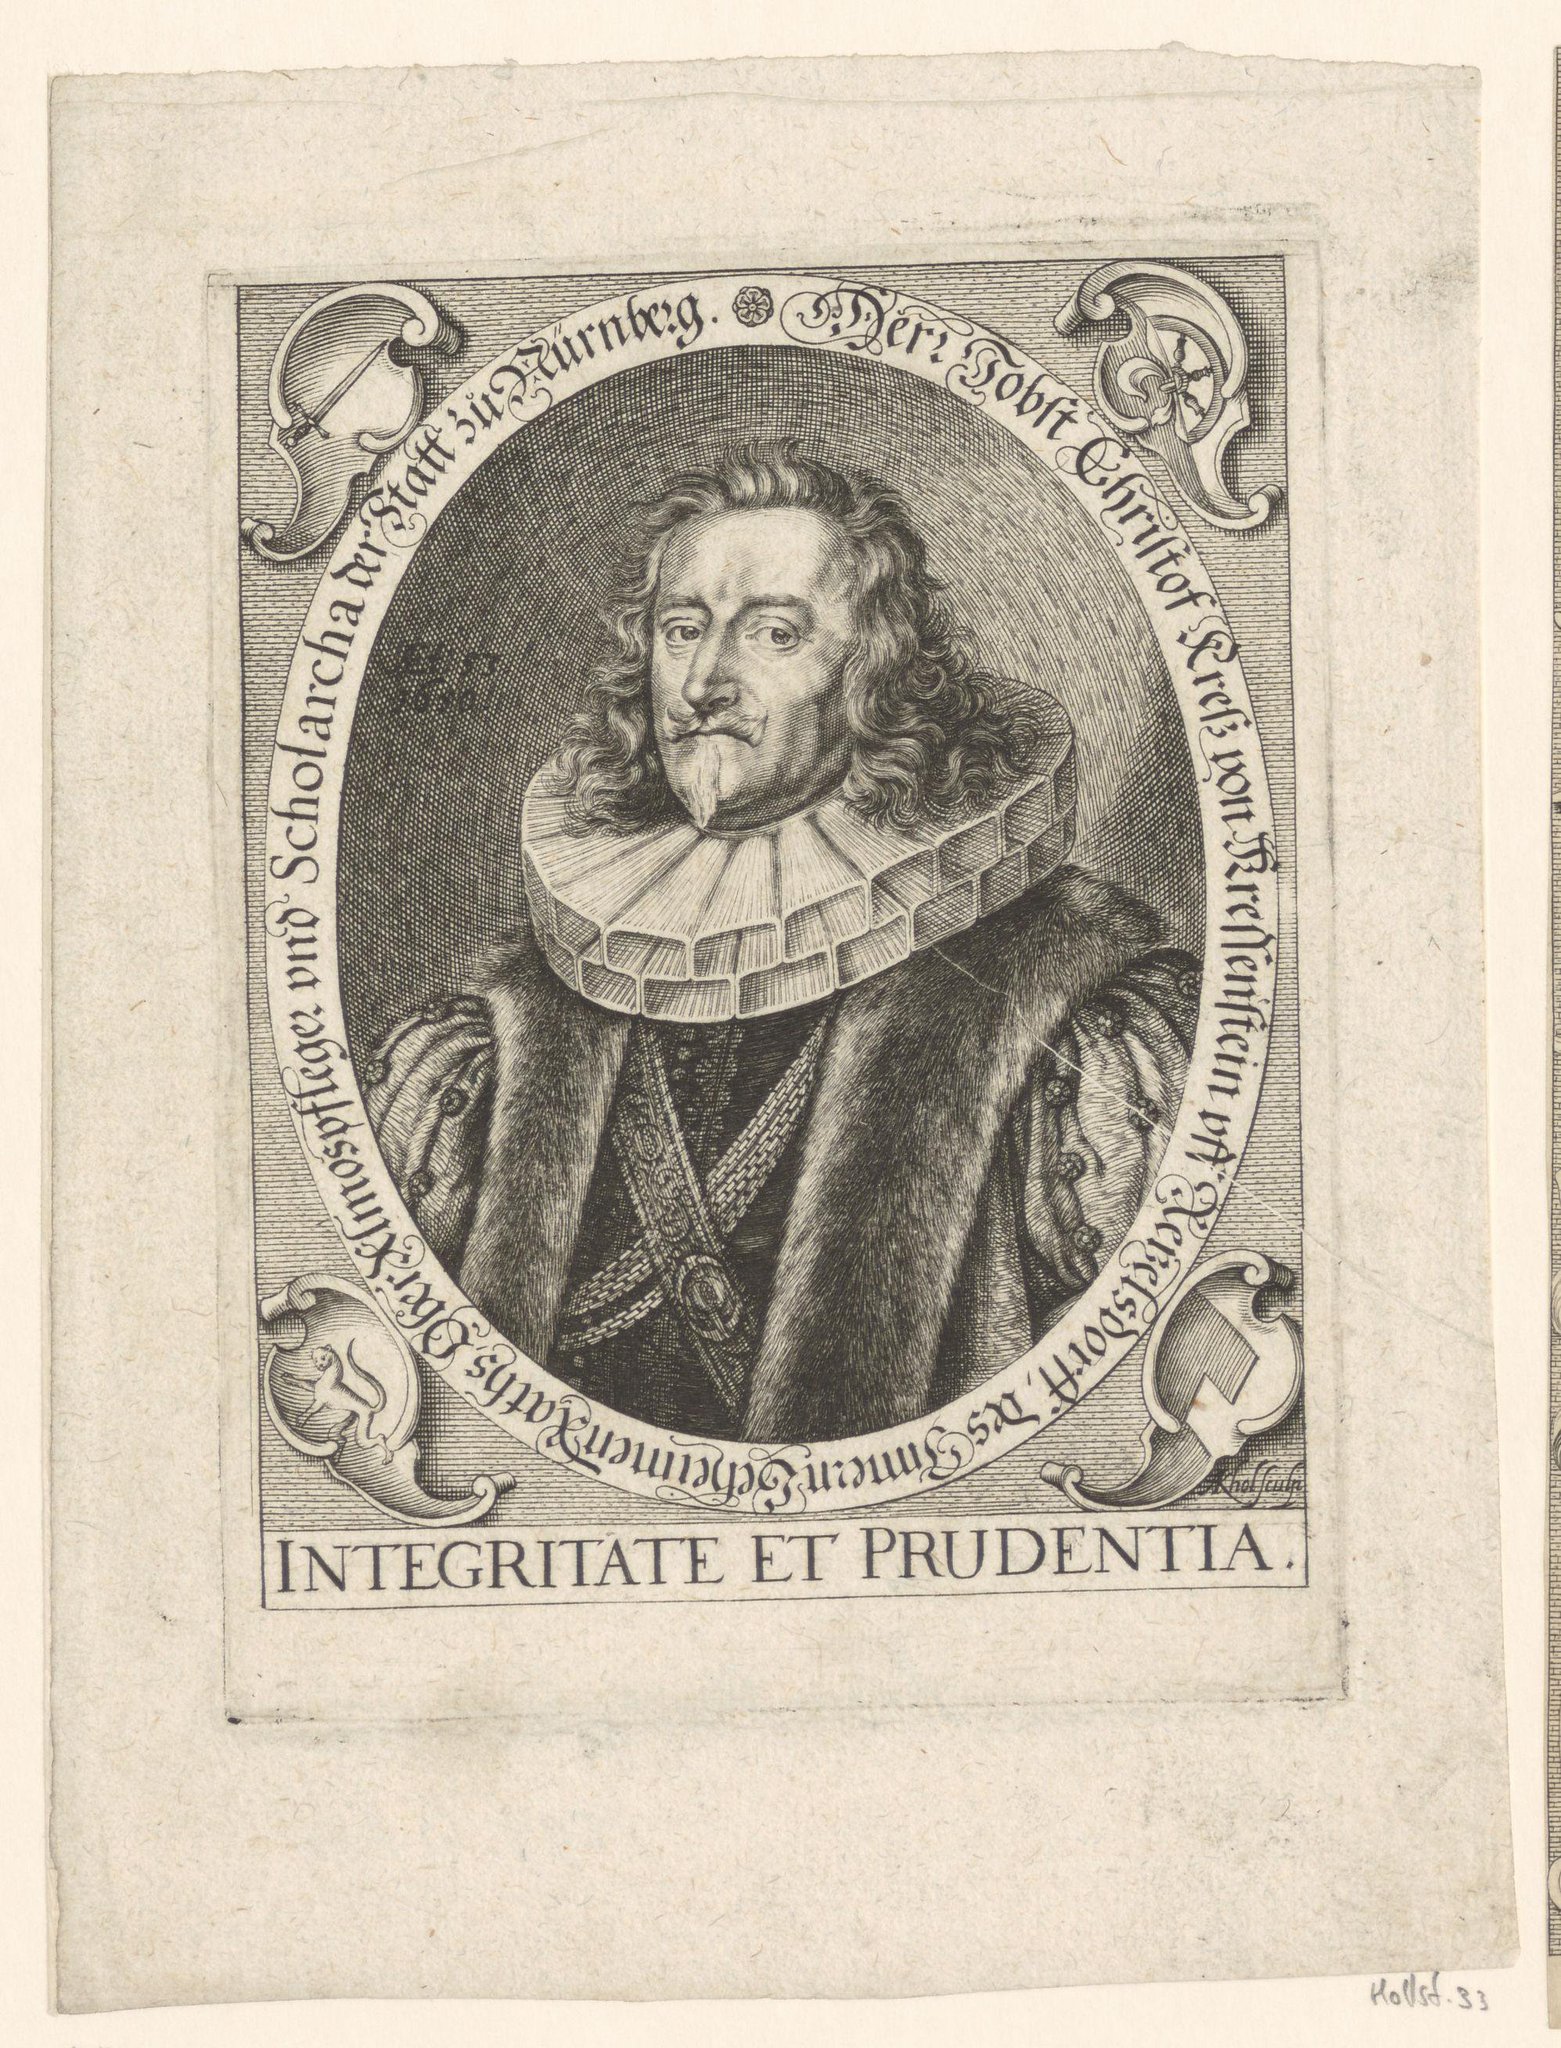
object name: print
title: Portret van Jobst Christoph Kress von Kressenstein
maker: andreas kohl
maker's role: print maker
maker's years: 1624-1657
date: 1650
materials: paper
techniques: engraving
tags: historical persons, lawyer, attorney at law, counsellor, diplomacy, diplomat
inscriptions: date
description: Tekst in het Duits in de omlijsting en een regel tekst in het Latijn in de ondermarge.